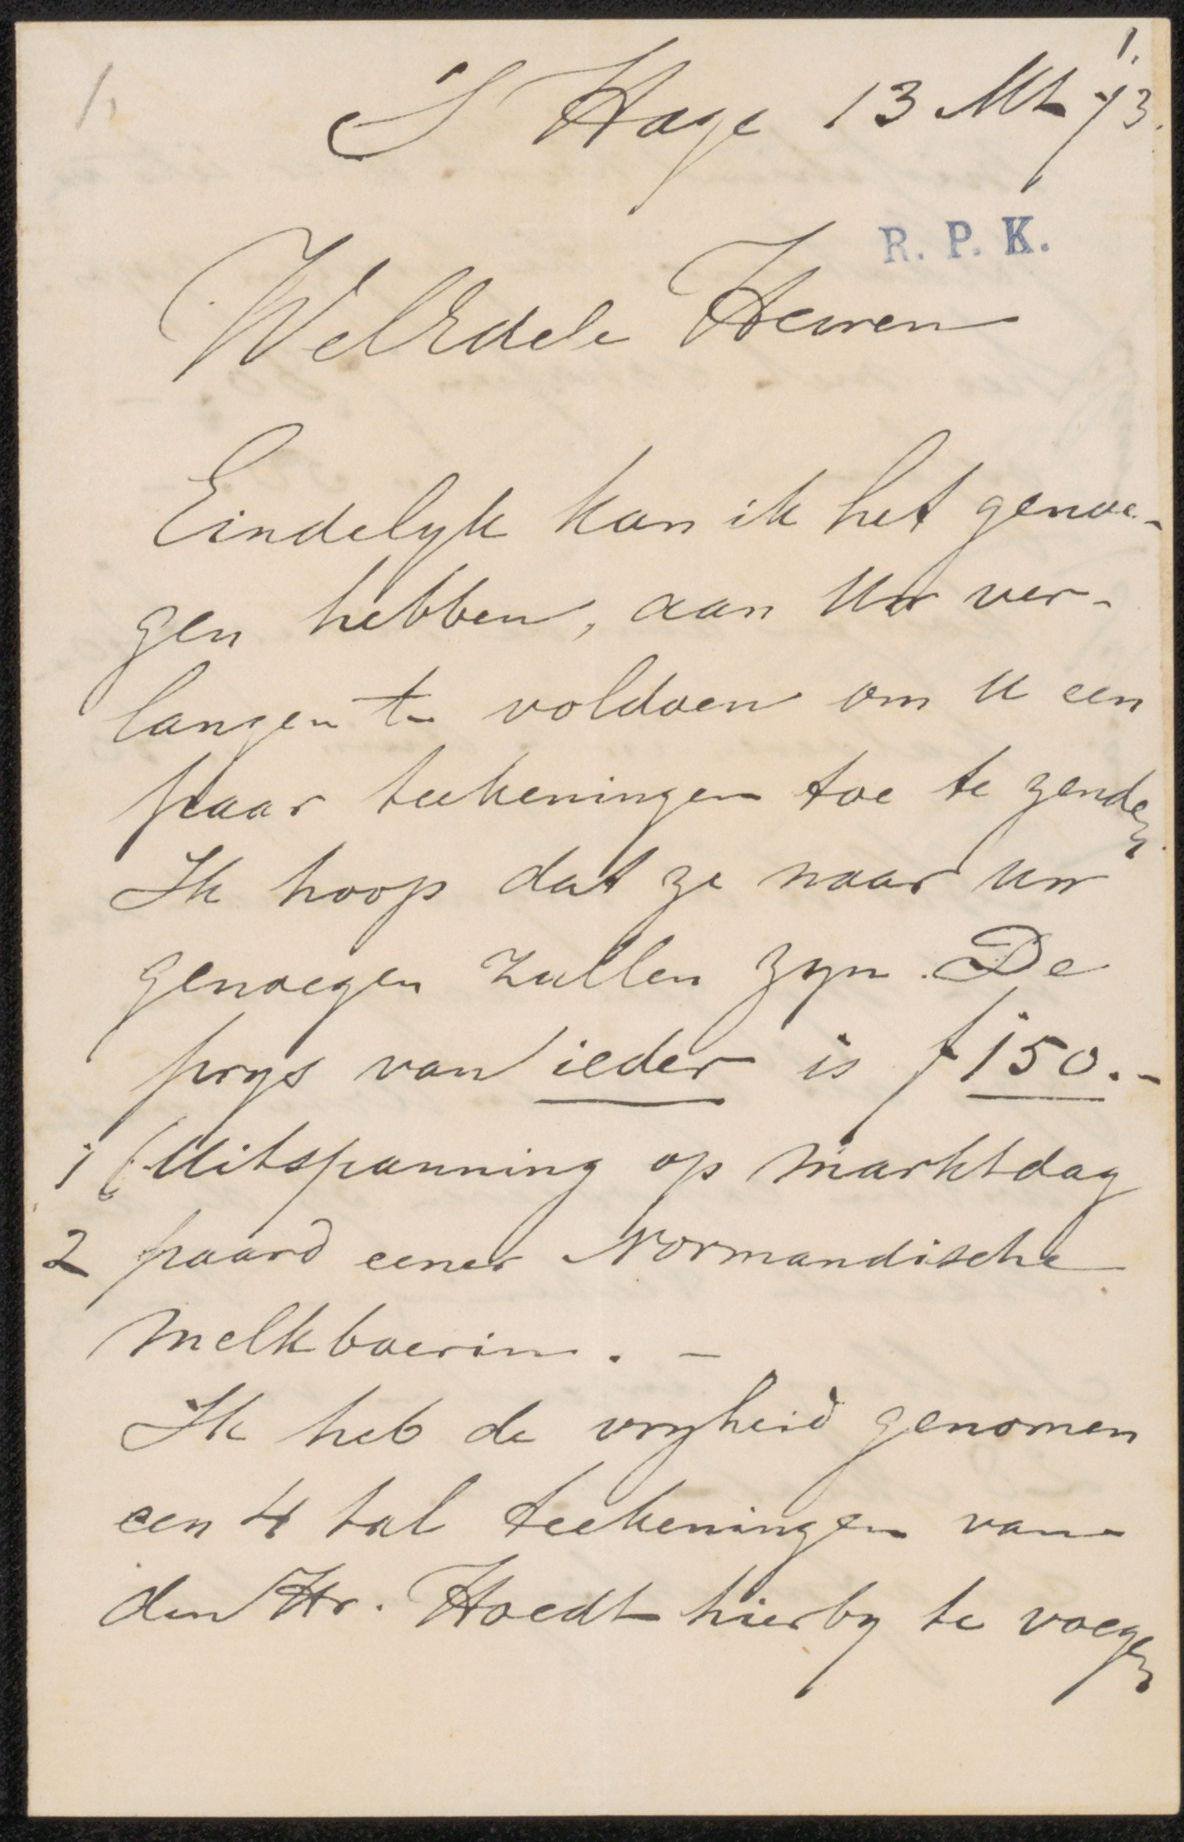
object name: letter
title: Brief aan anoniem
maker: willem carel nakken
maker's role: draughtsman, painter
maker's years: 1835-1926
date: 1873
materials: ink, paper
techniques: pen, writing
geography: the hague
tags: pieter louis hoedt, drawing, exhibition ~ art, money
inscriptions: collector's mark: Lugt 2233